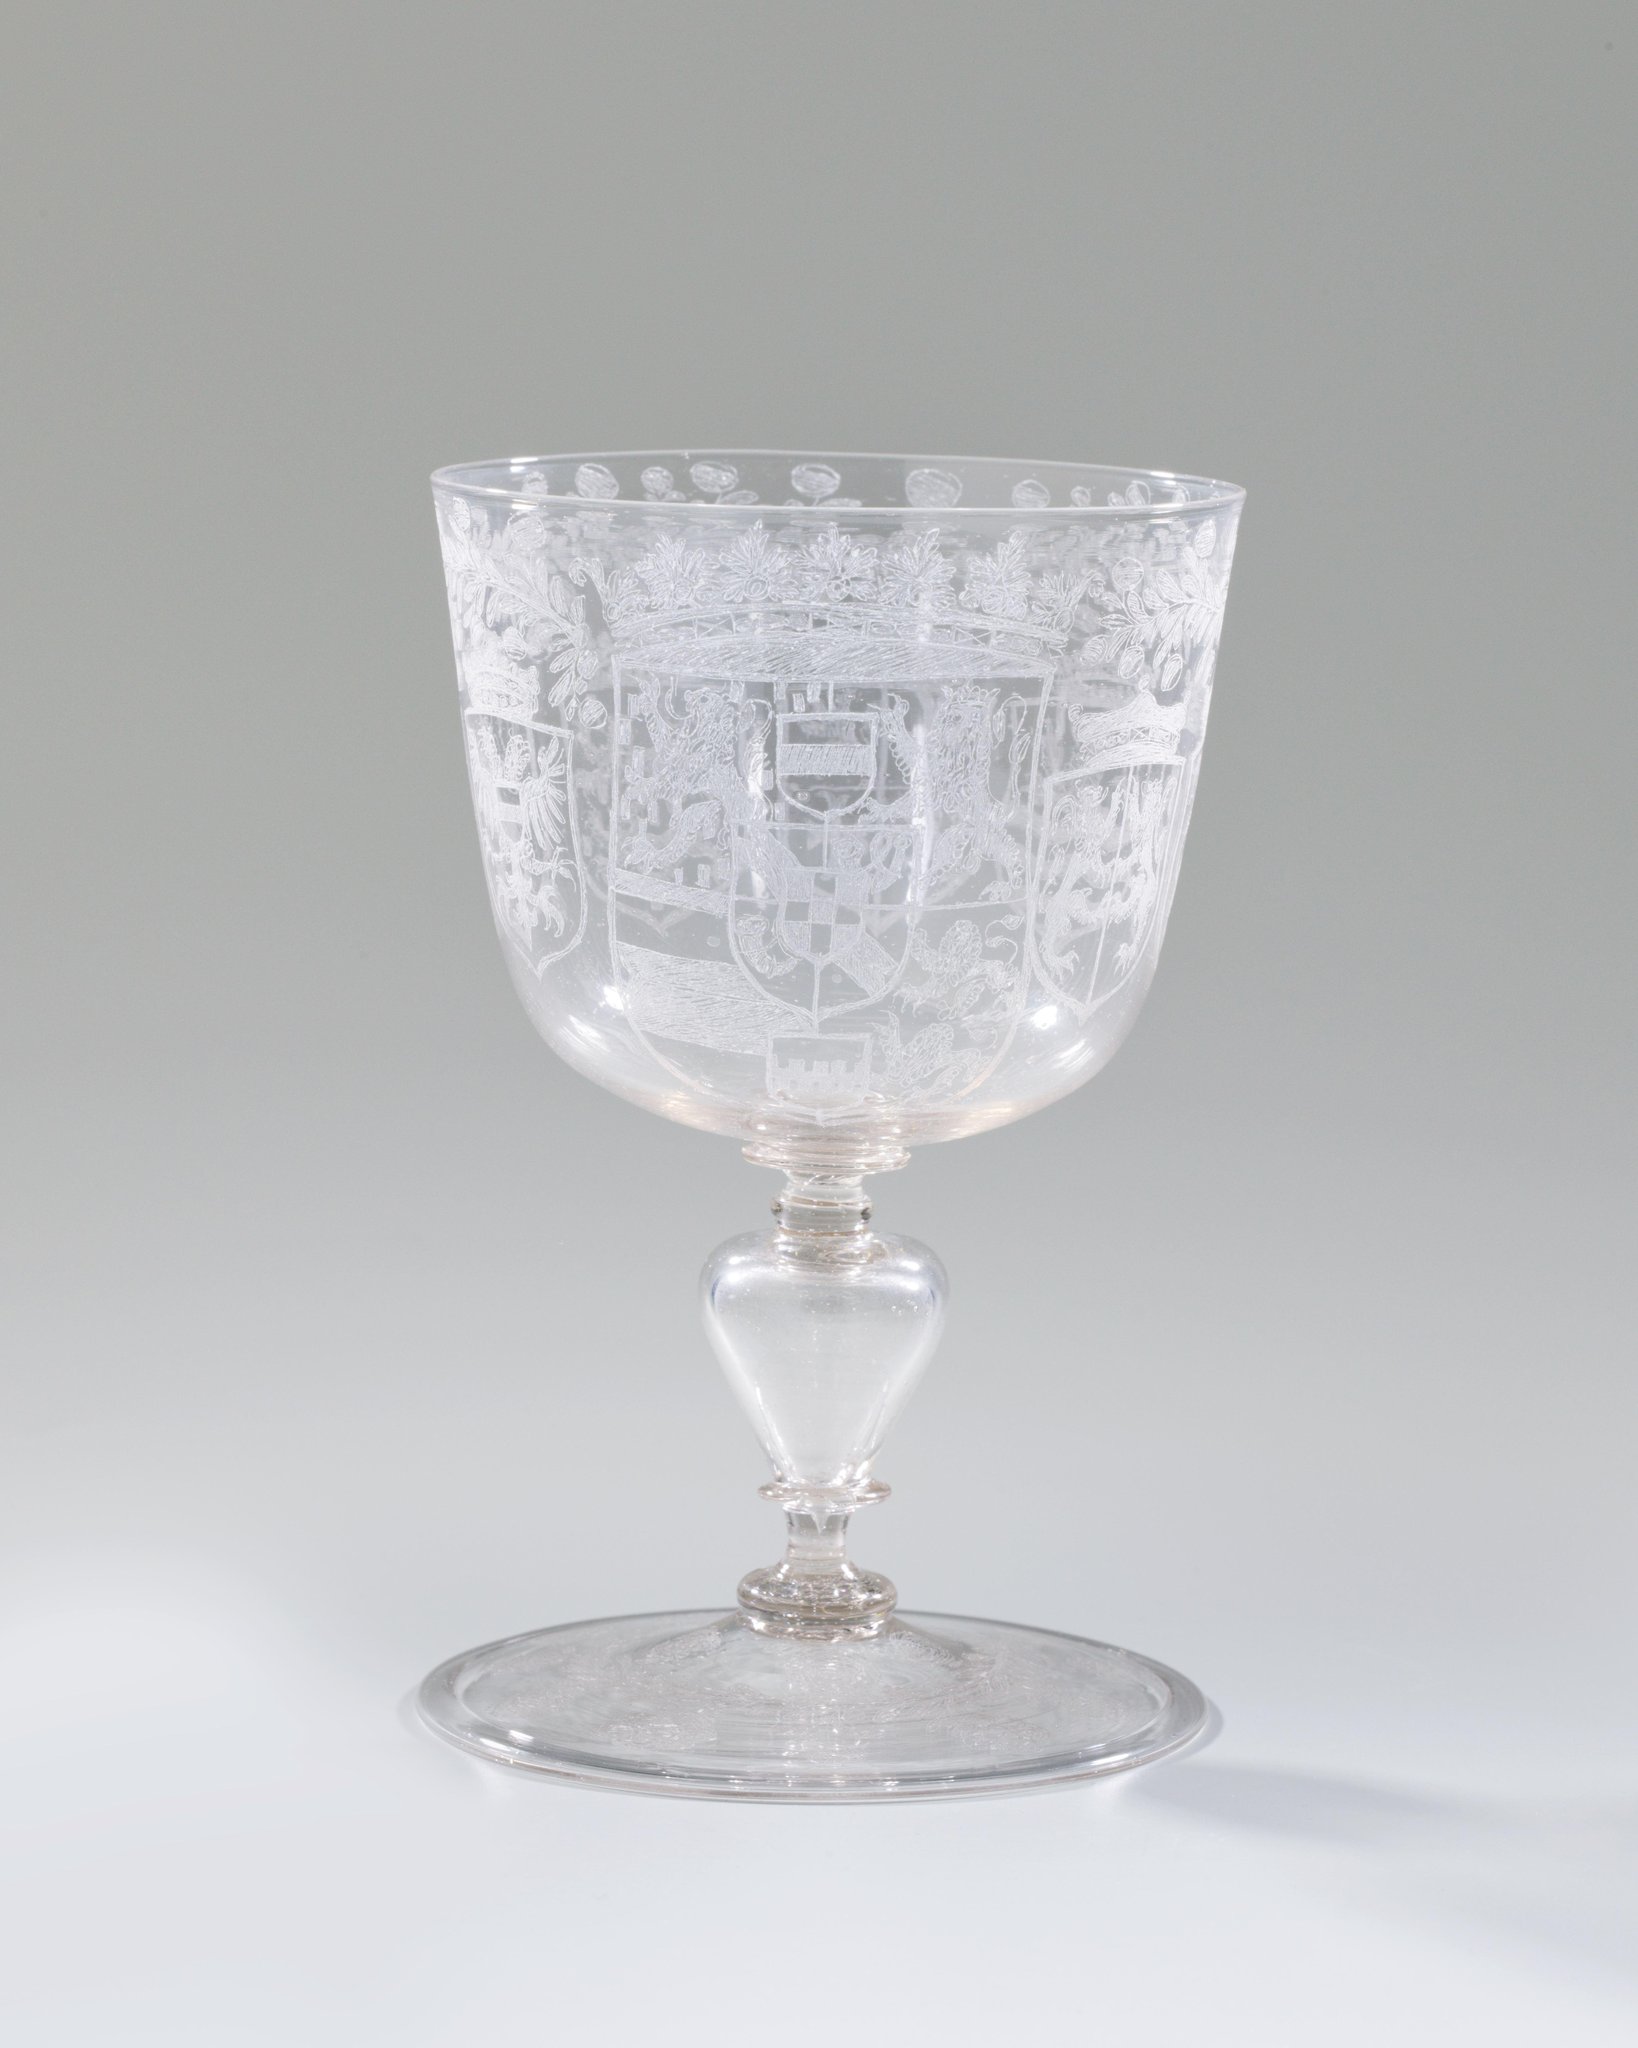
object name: goblet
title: Wine glass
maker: Anonymous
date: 1675-1700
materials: glass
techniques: diamond point engraving, façon de venise, glassblowing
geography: low countries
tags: the hague, william iii (prince of orange and king of england, scotland, and ireland), coat of arms (symbol of sovereignty)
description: The arms of Stadtholder William III are enclosed by the seven coats of arms of the Republic of the United Netherlands.